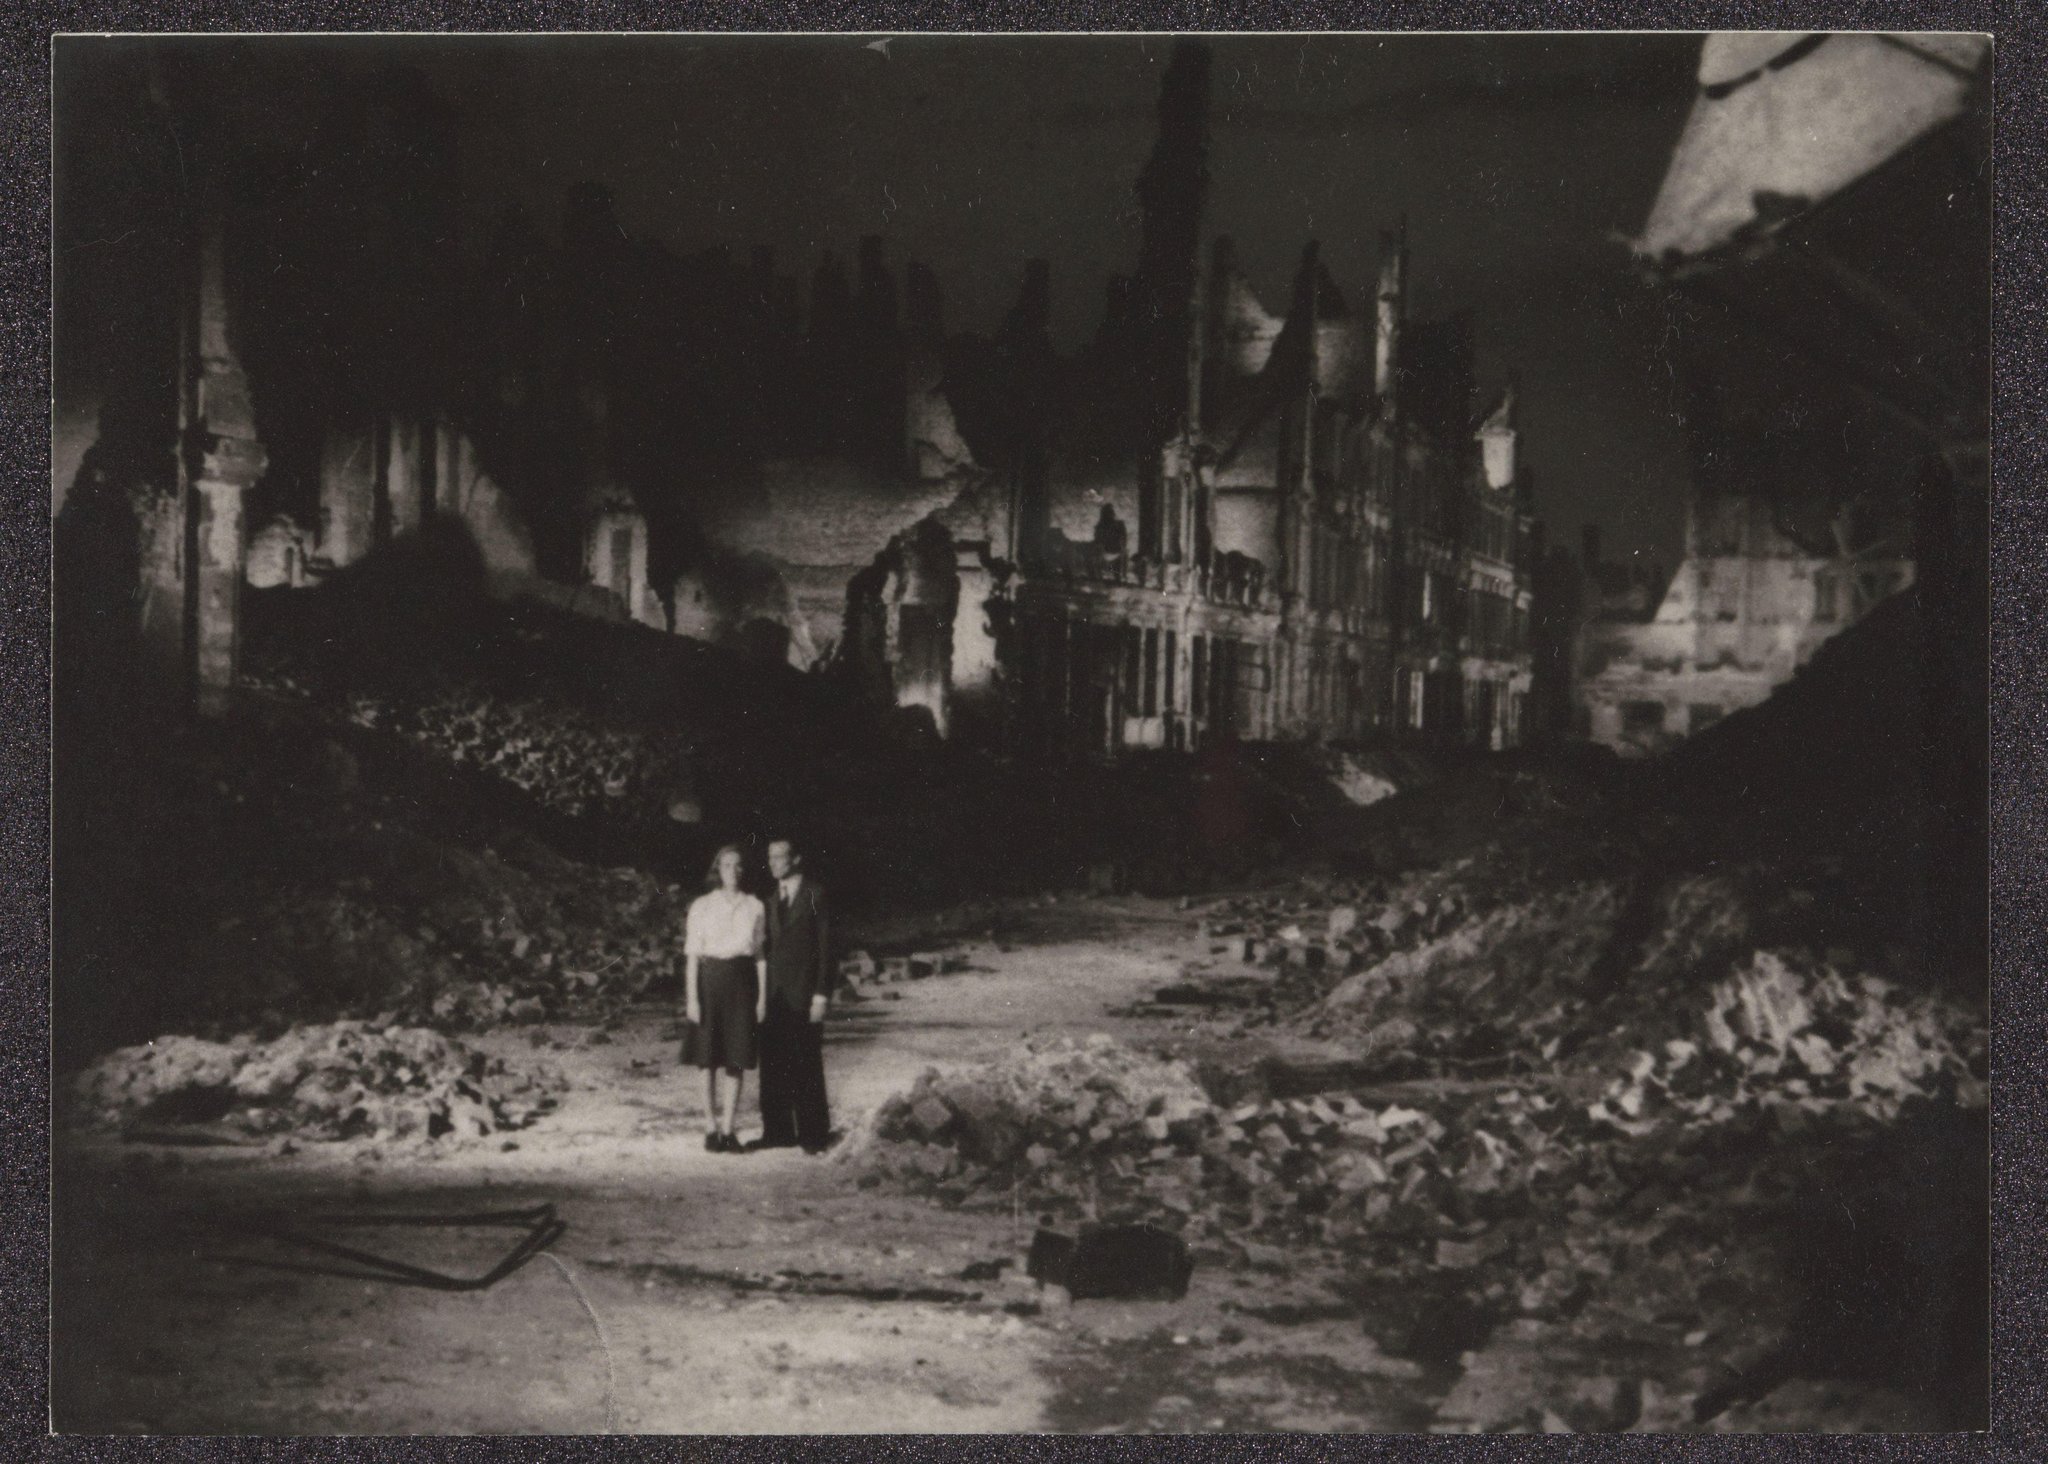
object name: photograph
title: Die Mörder sind unter uns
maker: Anonymous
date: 1946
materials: paper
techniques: gelatin silver print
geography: berlin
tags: berlin, ruin of a building ~ architecture, ruin of a dwelling, house, castle, etc.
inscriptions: stamp: ‘Nederlands Filmmuseum/ Amsterdam’, inscription: ‘Die Mörder sind unter uns/ O-Duitsl. 1946/ Wolfgang Staudte’, inscription: ‘Knef/ Borchert’